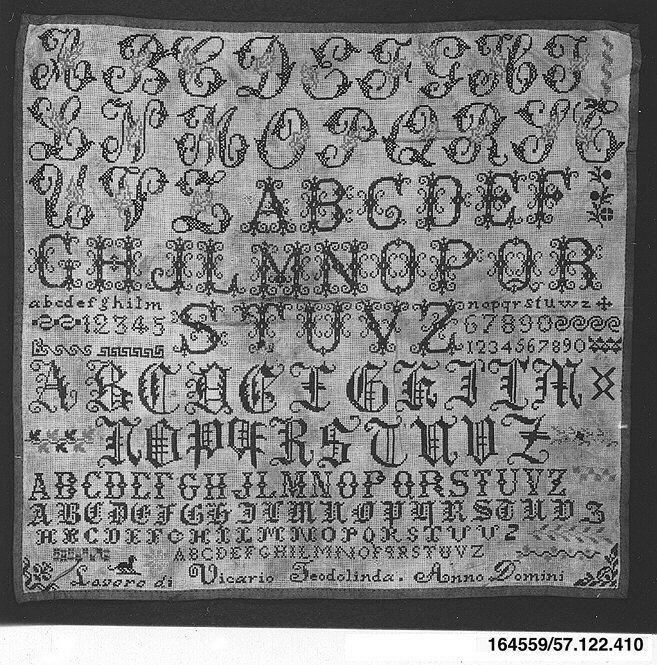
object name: sampler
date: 1801-1900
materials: canvas, cotton, silk